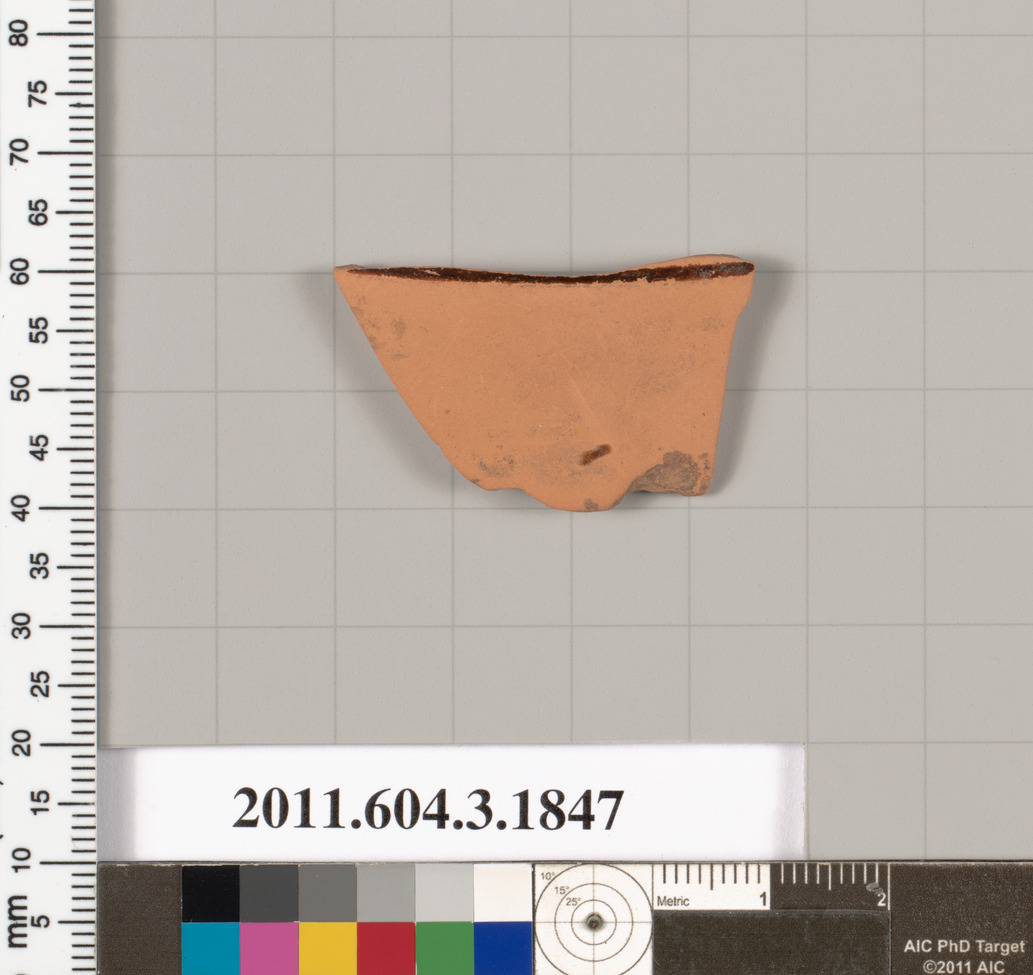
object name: kylix fragment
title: Terracotta fragment of a kylix: Lip cup (drinking cup)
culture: greek, attic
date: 560-525 BCE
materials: terracotta